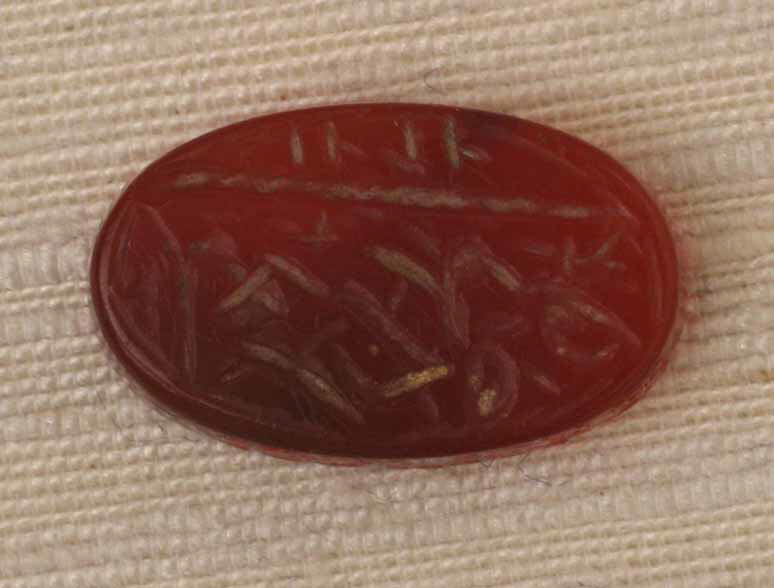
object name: stamp seal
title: Seal Stamp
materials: stone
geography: iran